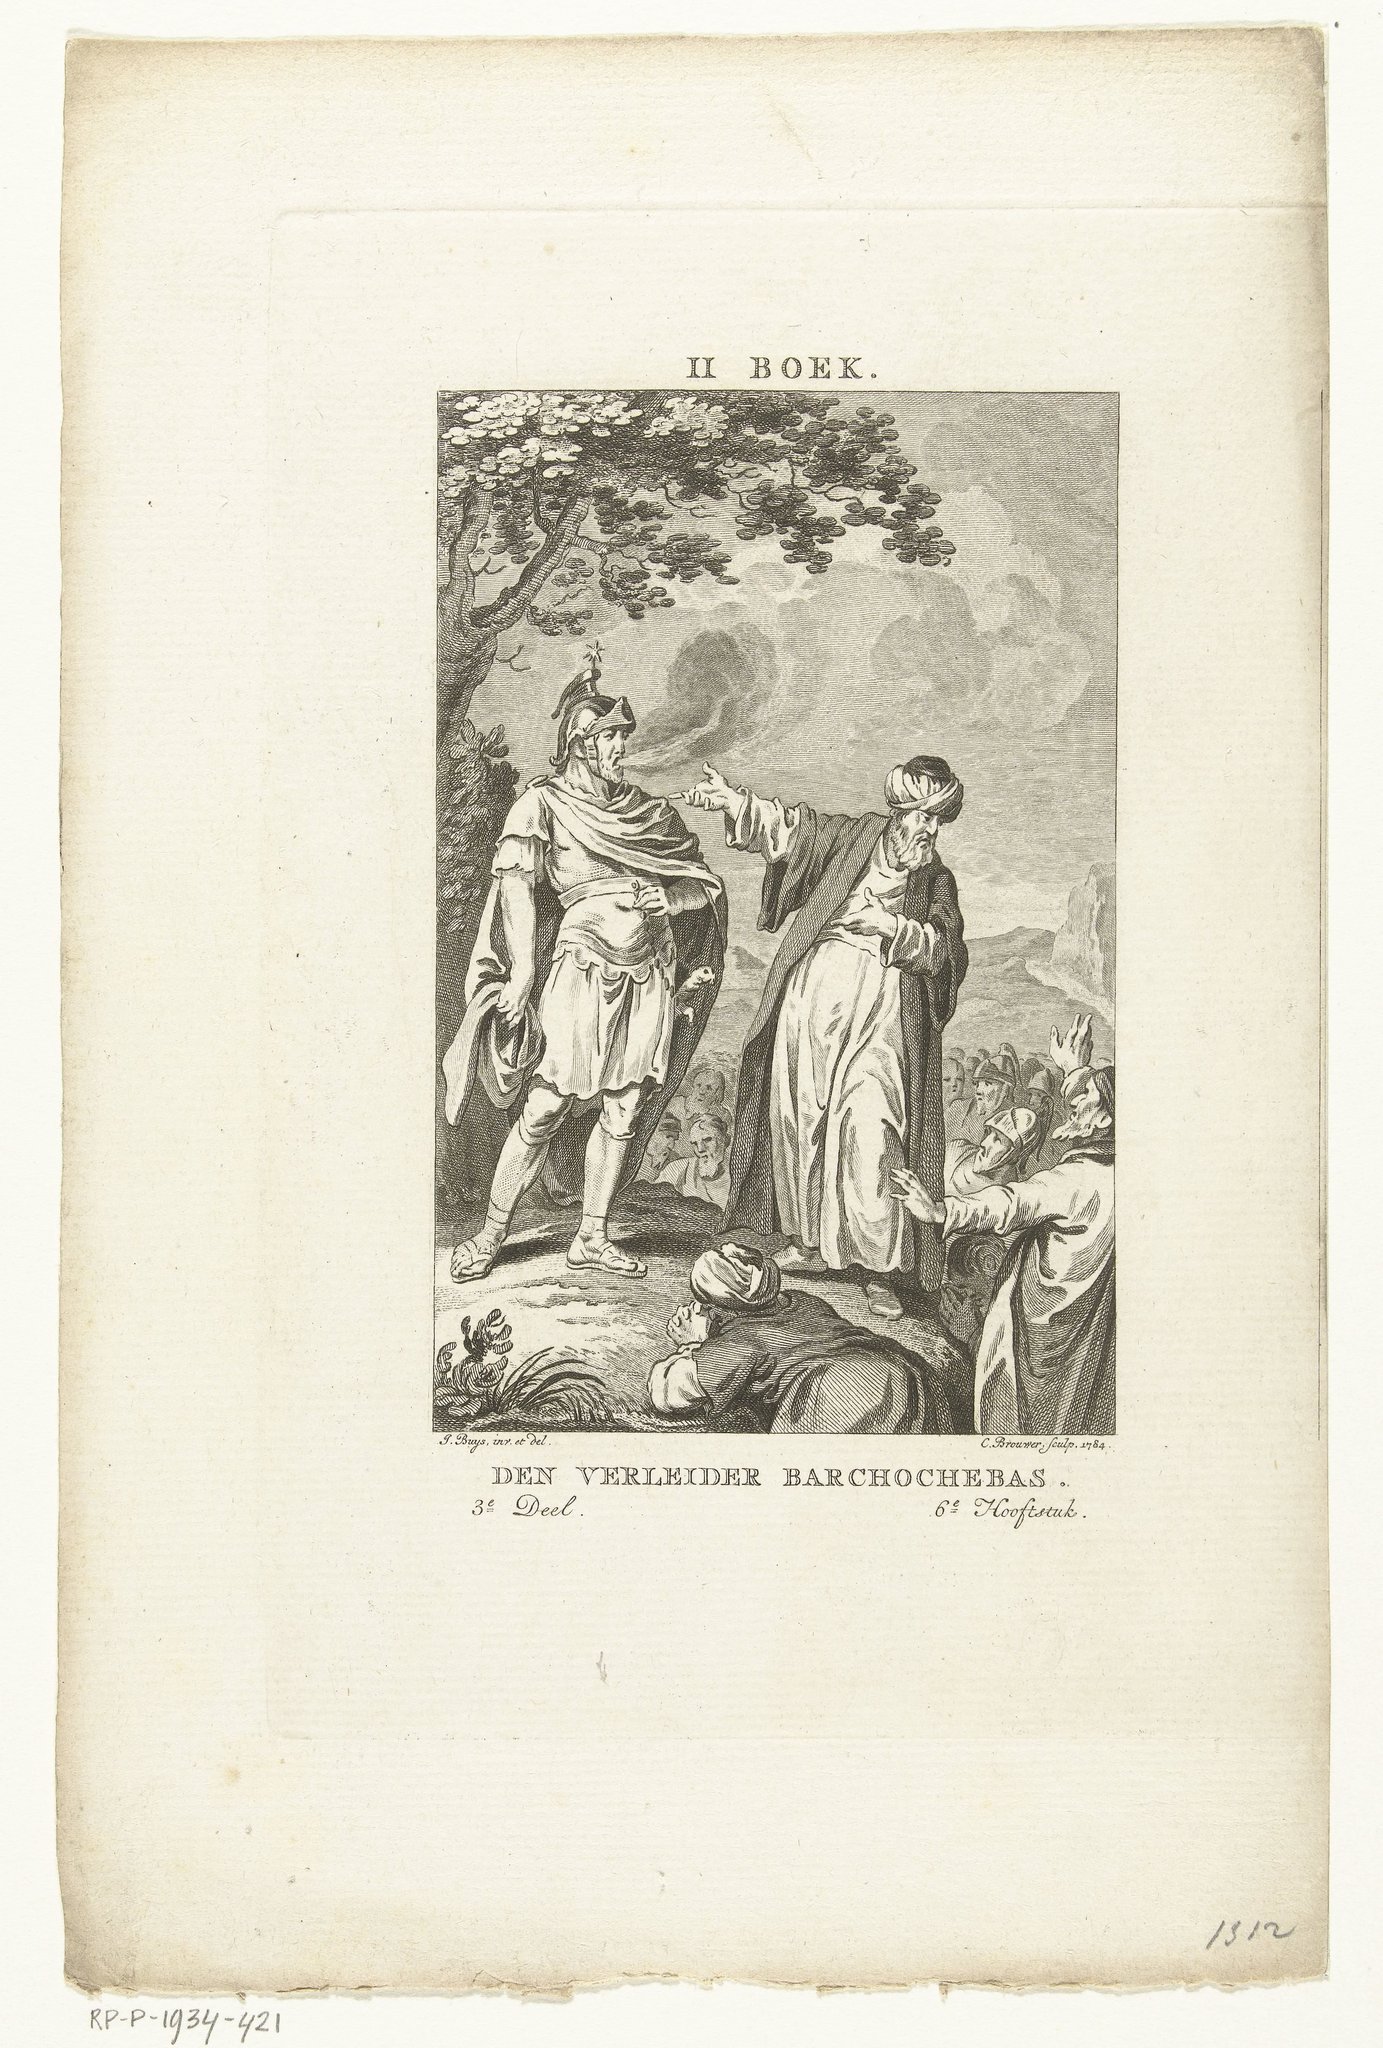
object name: print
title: Joodse leider Barchochebas (Simon ben Kosiba) toont vuurspuwende Romein aan Joodse leger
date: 1784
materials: paper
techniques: etching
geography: netherlands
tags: dispute of christians and jews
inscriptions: collector's mark: Lugt 2228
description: Joodse leider Simon ben Kosiba, bijgenaamd Simon bar Kochba (Barchochebas) was een Joodse messias. Tussen 132 en 135 was hij leider van de laatste opstand tegen de Romeinen. Hij probeert hier mannen te overtuigen van zijn rol als Messias en toont een vuurspuwende Romein aan het Joodse leger, zij reageren met ontzag.